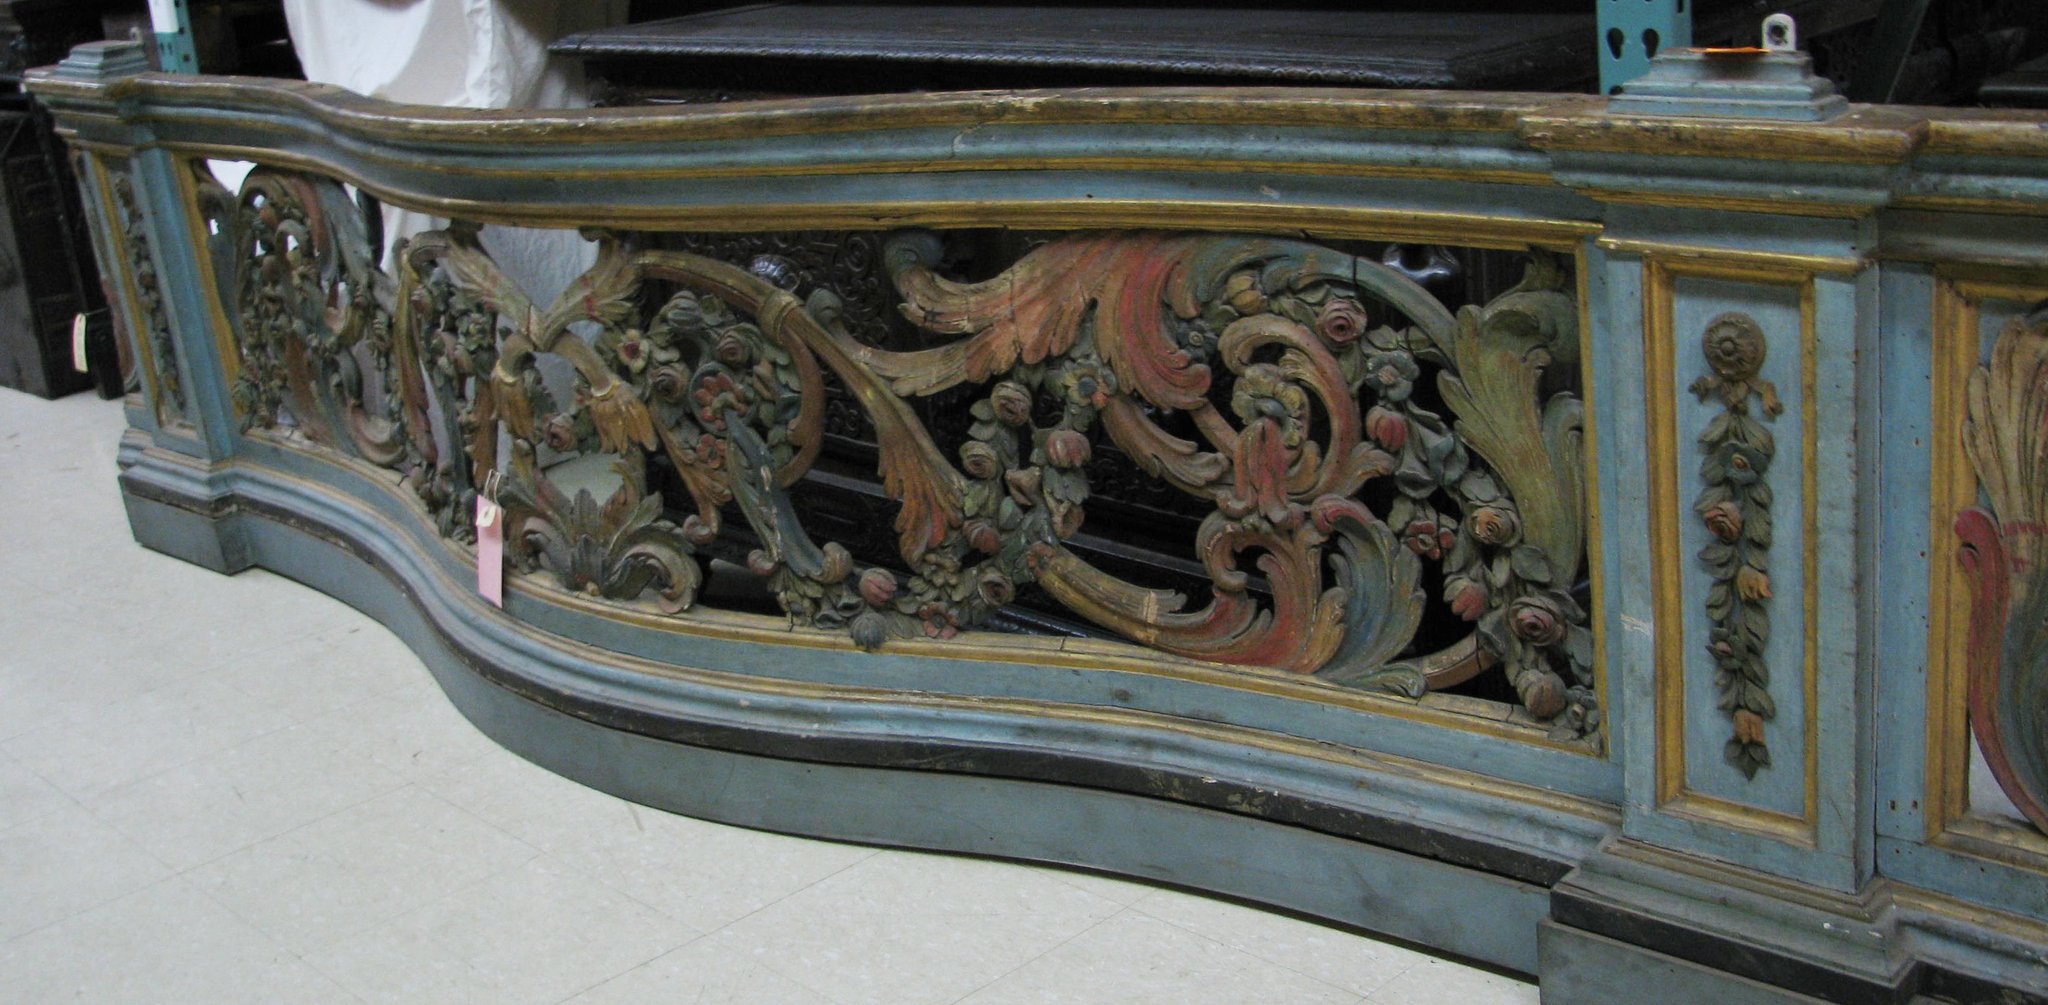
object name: balcony front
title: Front of balcony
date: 1750-1800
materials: gilt, wood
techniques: polychrome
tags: flowers